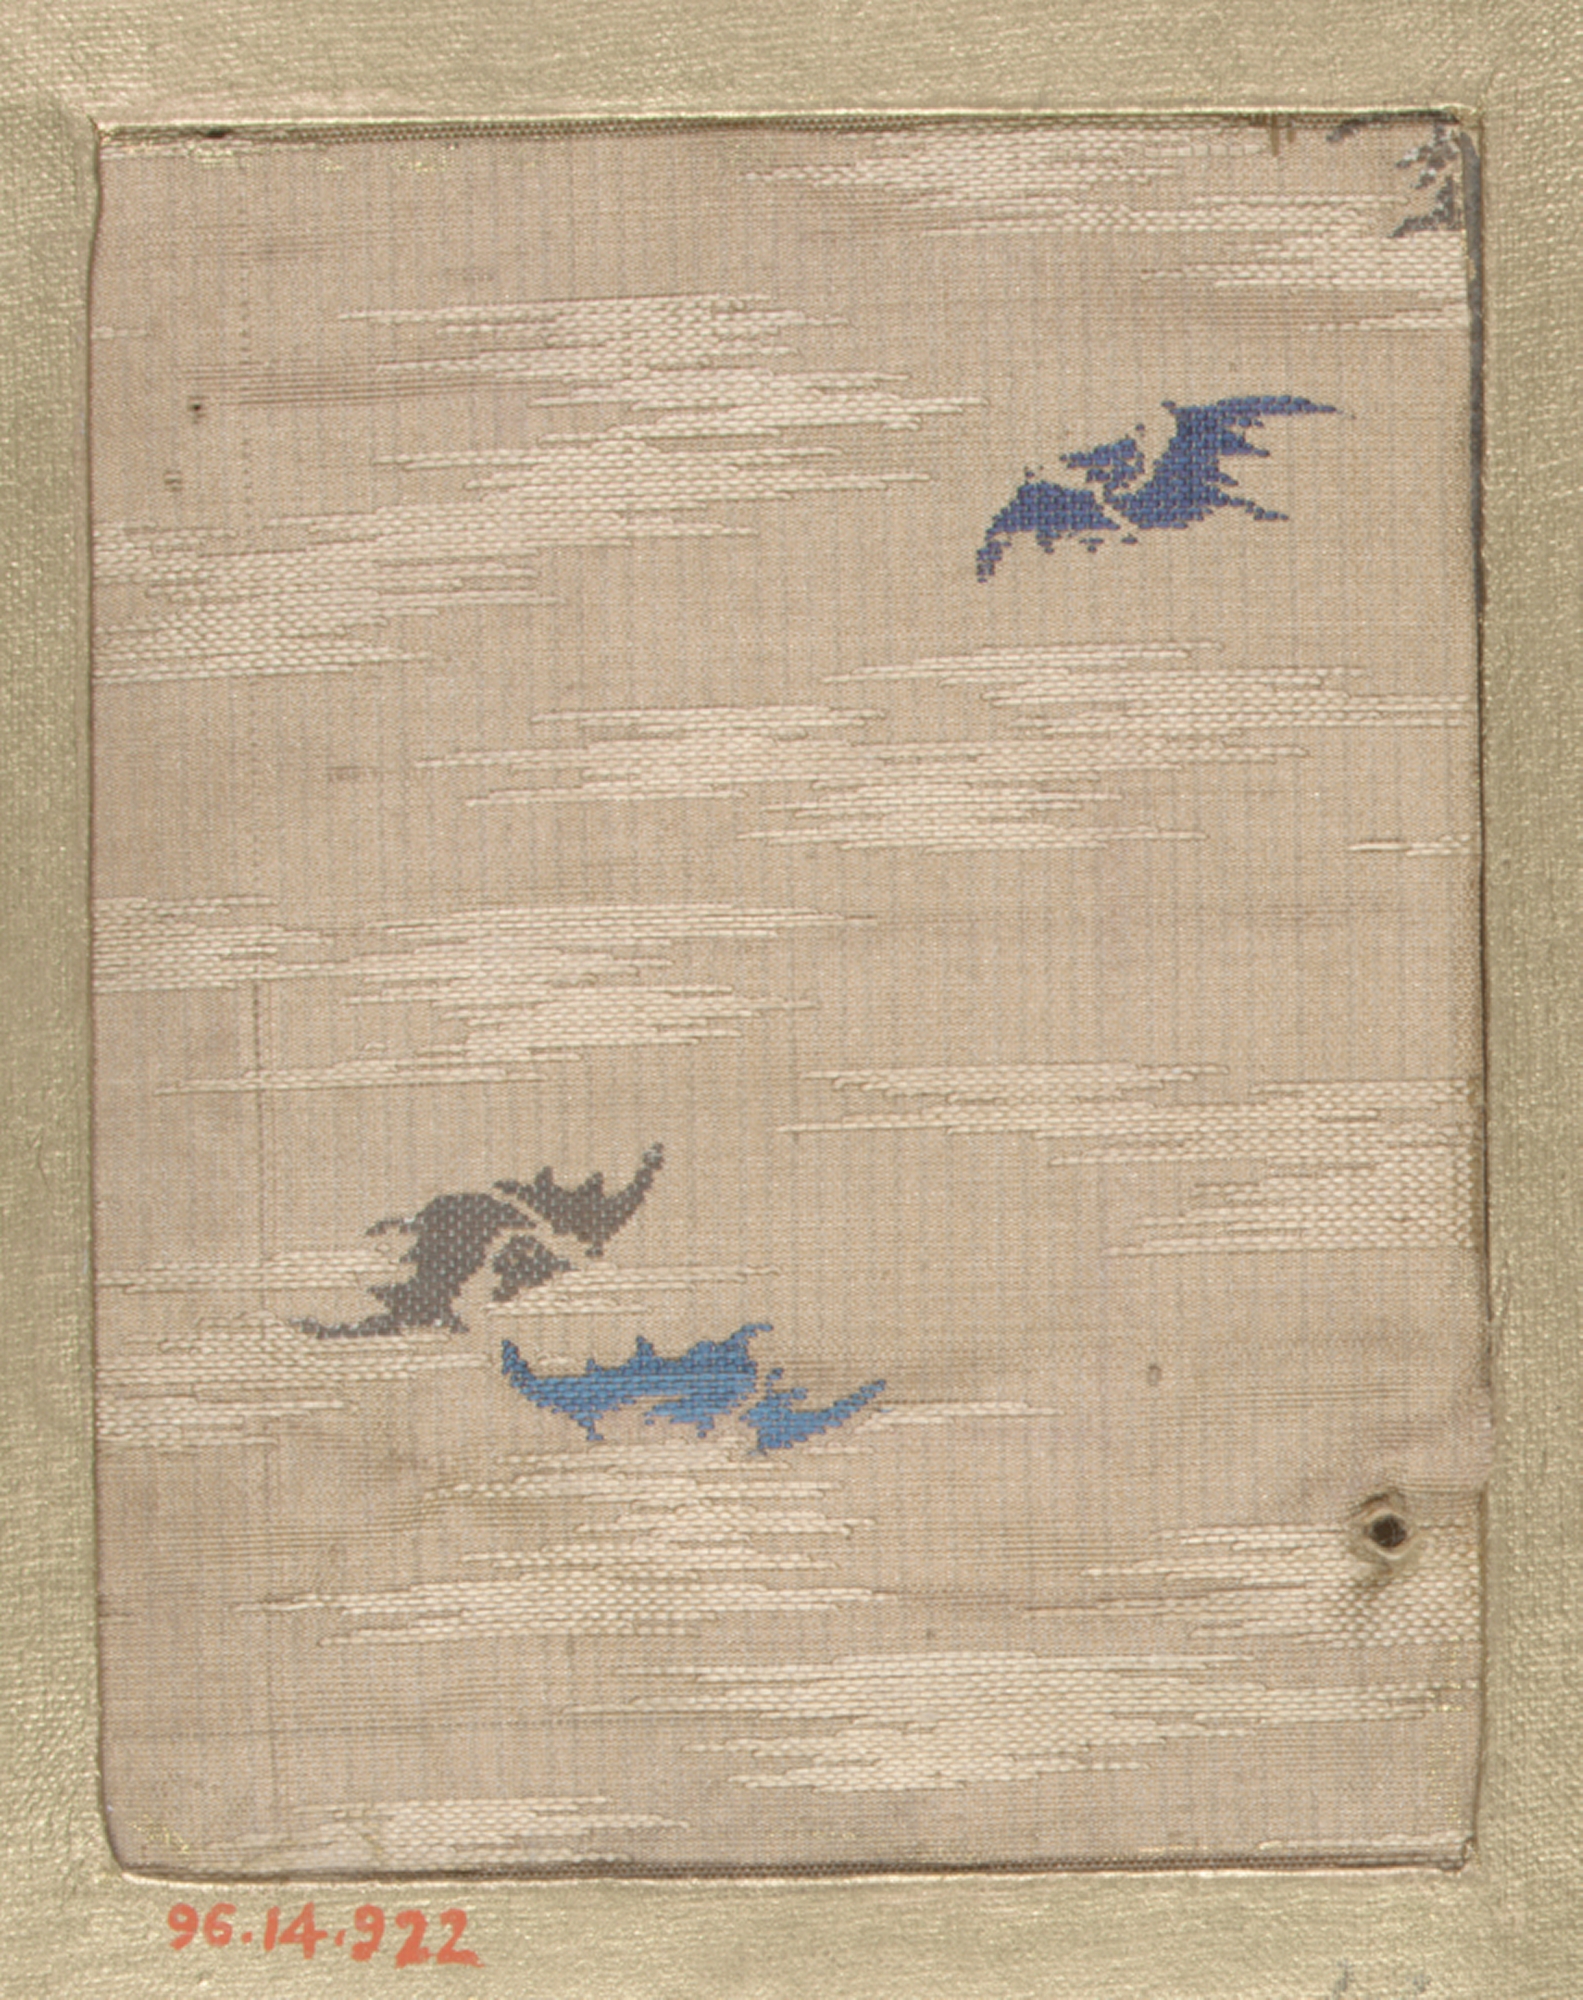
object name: piece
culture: japanese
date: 1701-1900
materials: silk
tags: bats